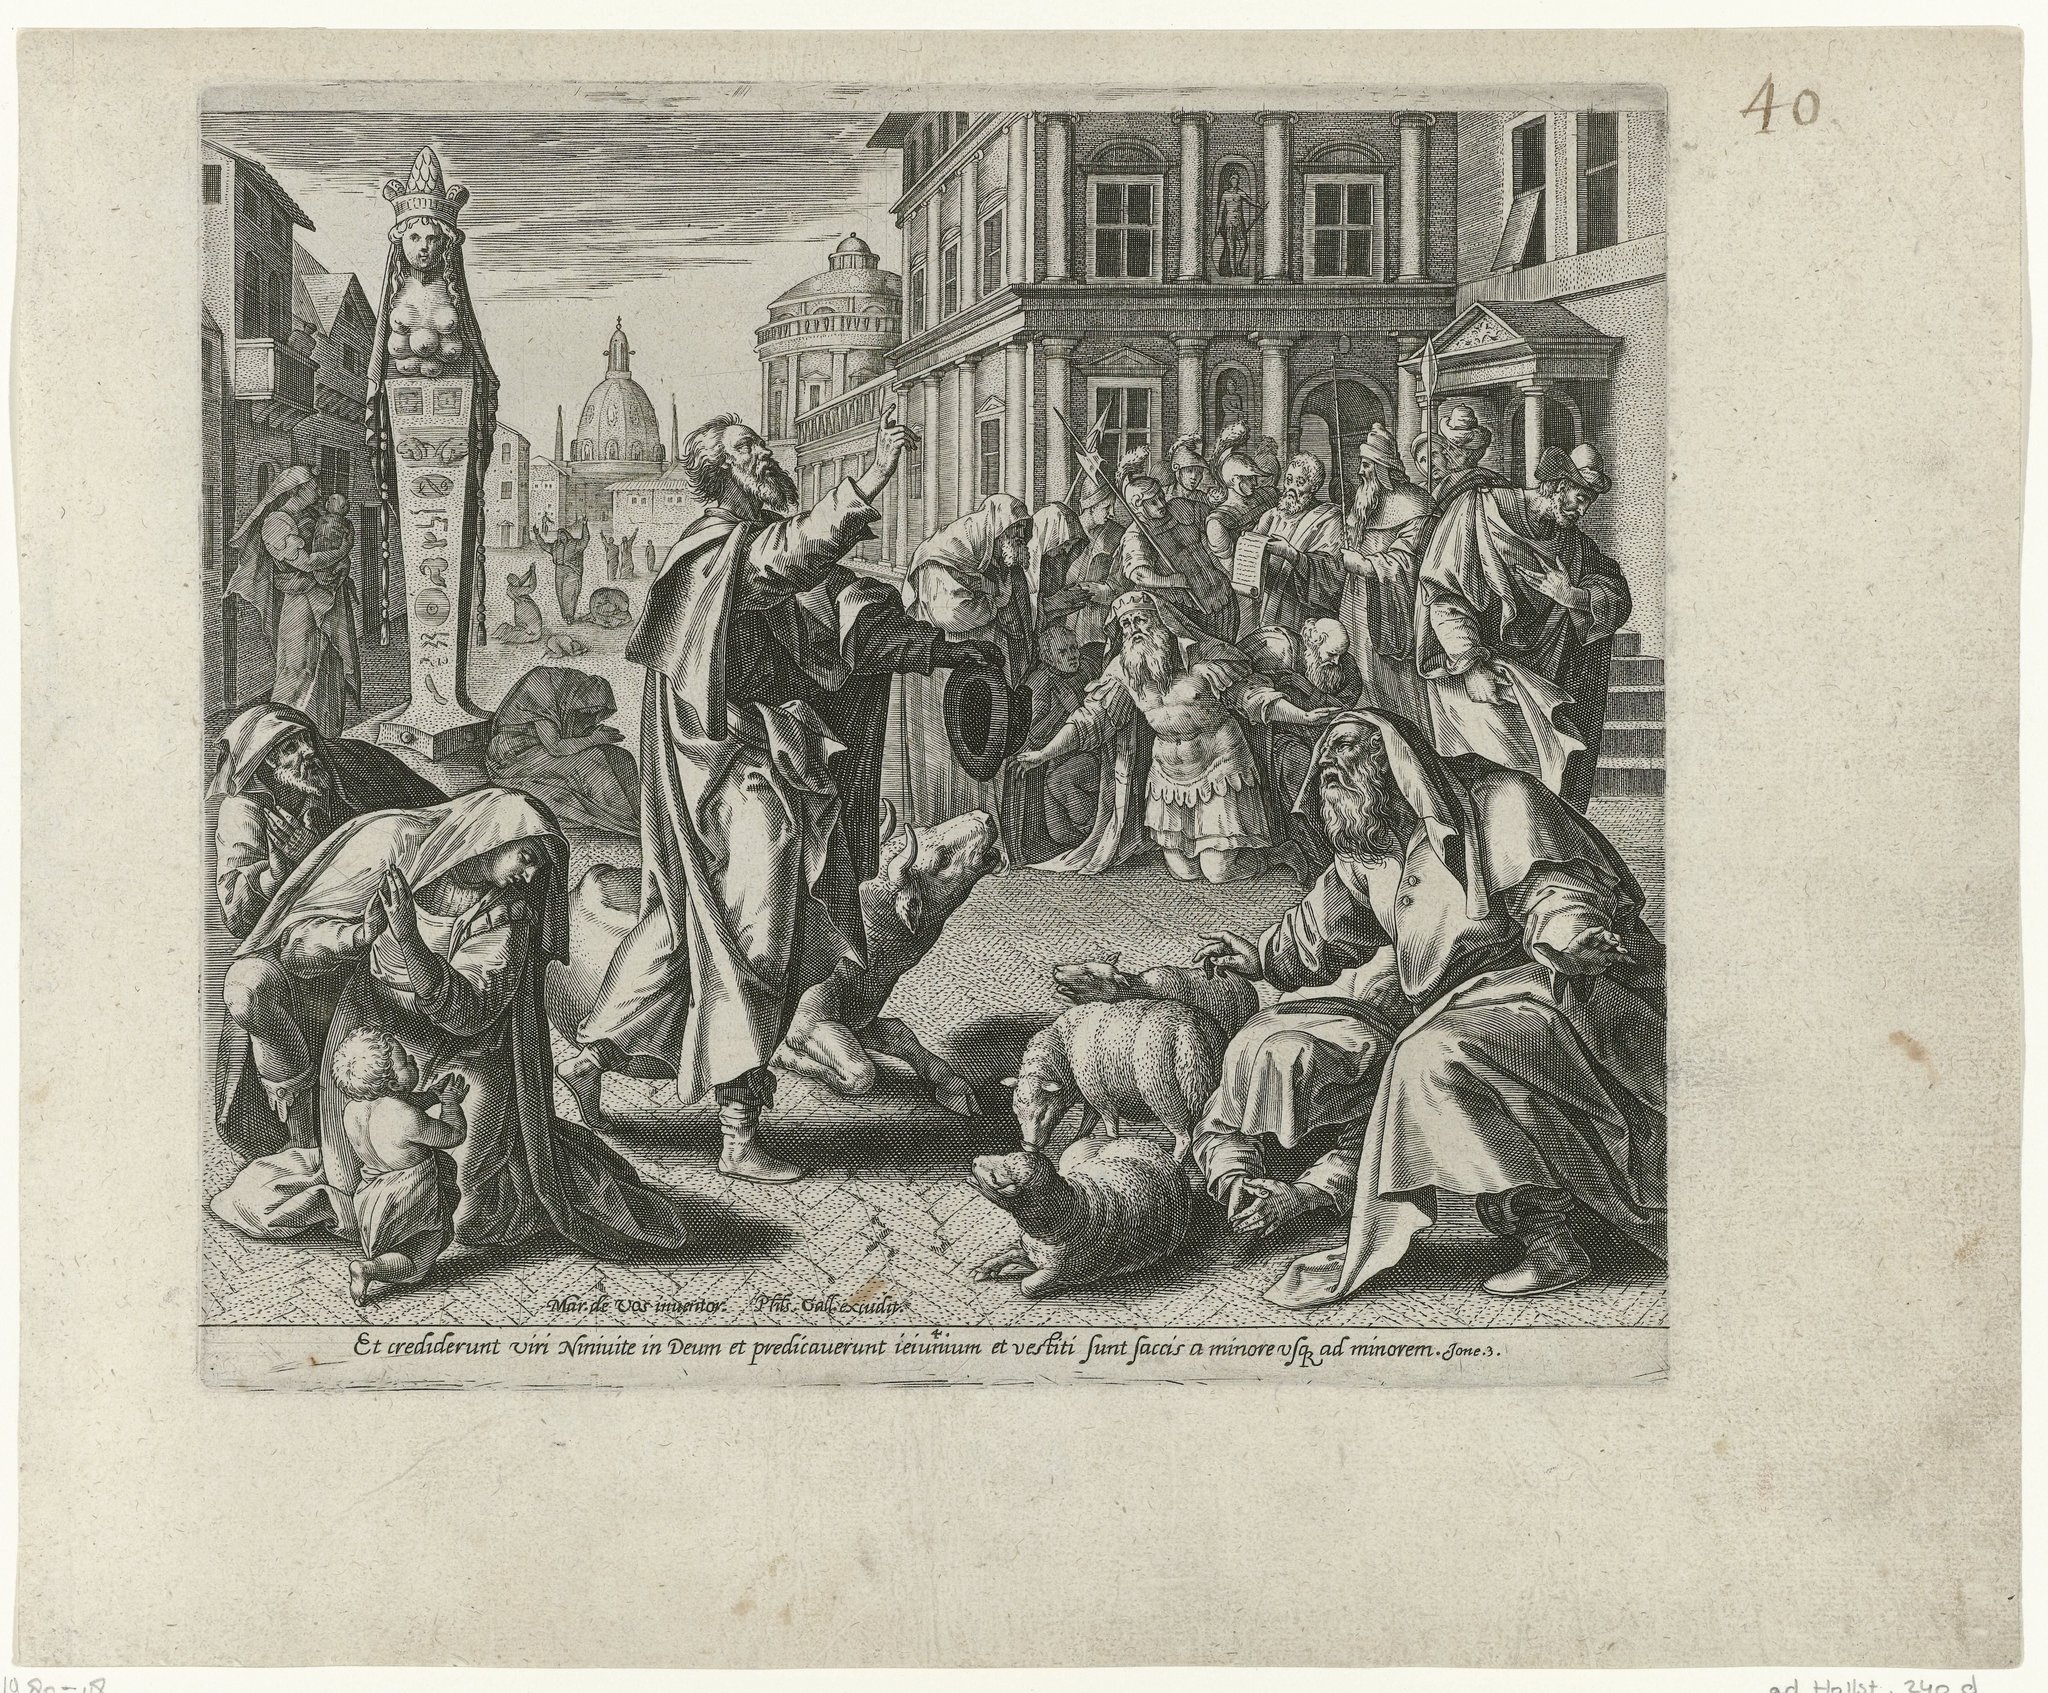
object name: print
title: Typus Divinae indulgentiae atqz misericordiae, erga eos quibus ex toto corde transgressionum poeni tet et ad dnm deum se convertunt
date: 1547-1612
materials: paper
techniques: engraving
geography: antwerp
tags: when the king of nineveh hears about the destruction of the city in forty days, he rises from his throne and decrees a general repentance for man and animal: all men, cattle and sheep must fast, people must wear sackcloth and pray to god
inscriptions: collector's mark: Lugt 2228, collector's mark: Lugt 2760, number: ‘40’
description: Jona bewandelt de straten van Nineve en verkondigt de ondergang van de stad omwille van afgoderij. De inwoners en de dieren van Nineve knielen op de grond en smeken God berouwvol om vergiffenis. Ook de koning werpt zich op de grond. De prent heeft een Latijns onderschrift en is deel van een serie over boetedoening en berouw in het Oude en Nieuwe Testament.